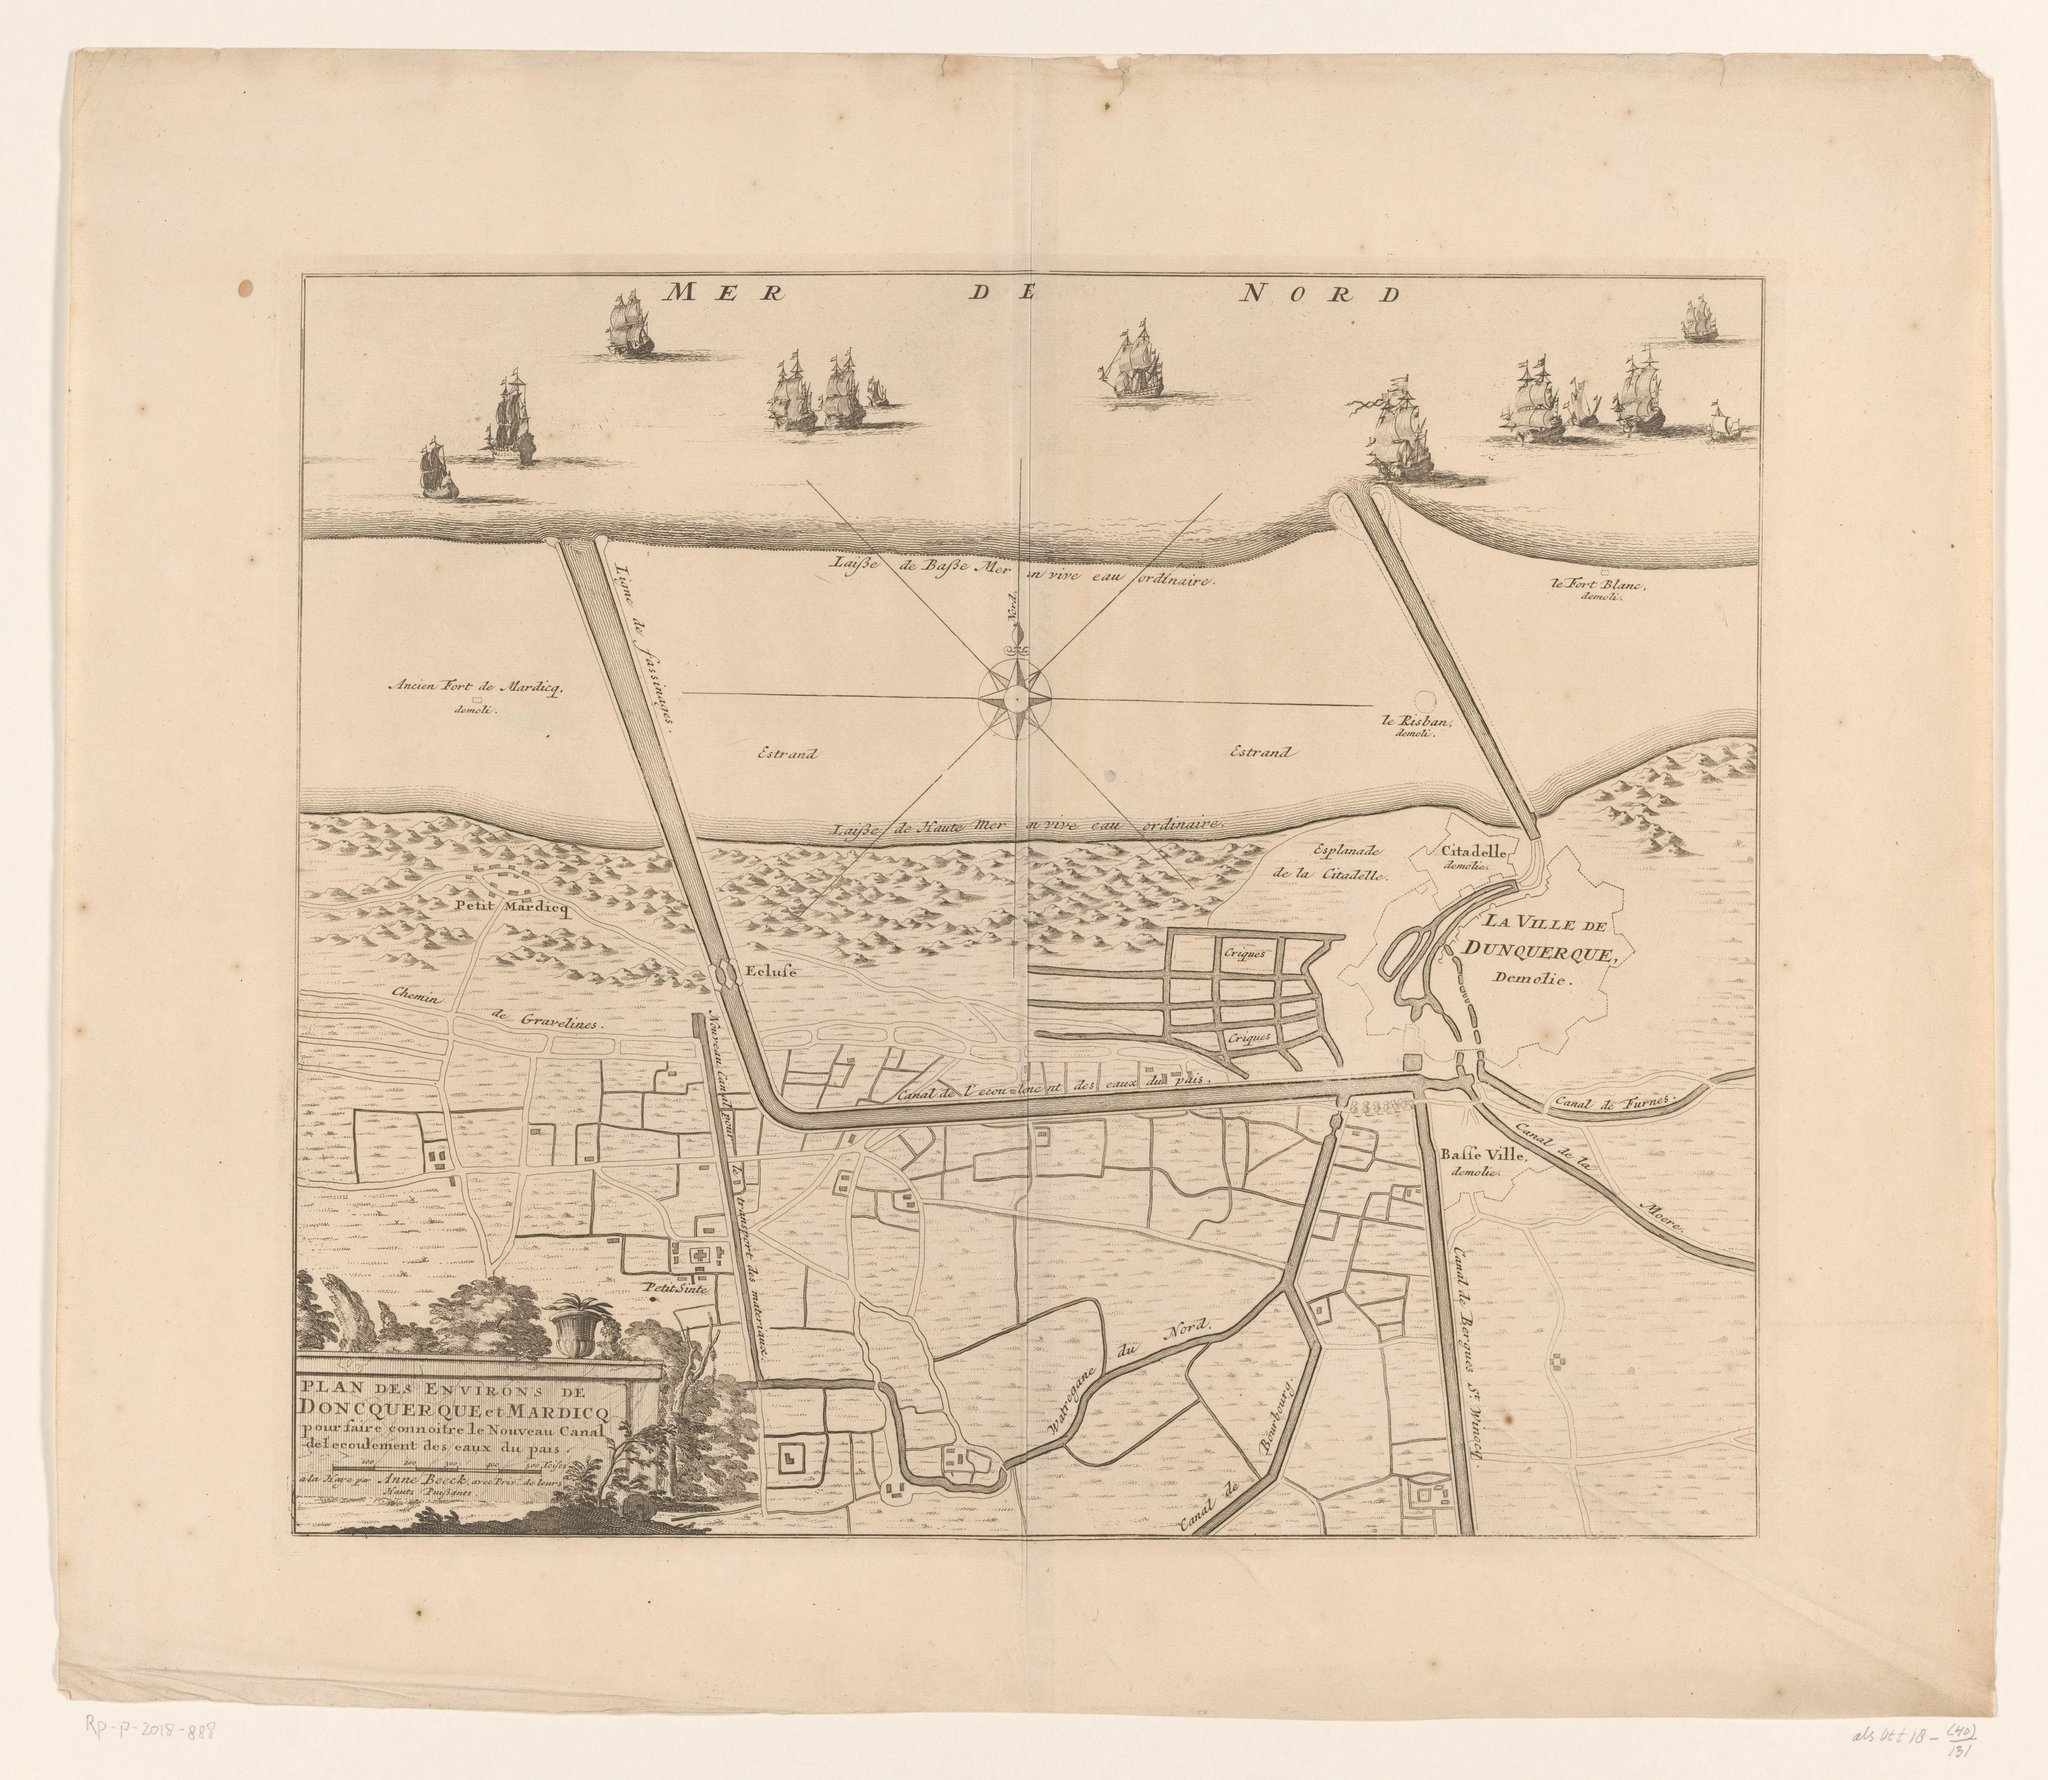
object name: print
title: Plan des environs de Doncquerque et Mardicq pour faire (...)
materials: paper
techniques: engraving, etching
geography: the hague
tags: construction of canal, maps of separate countries or regions, canal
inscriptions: collector's mark: Lugt 2228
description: Kaart met de kanalen van Duinkerke. Te zien is een nieuw gebouwde kanaal, dat Sint-Winoksbergen direct met de zee zou verbinden. Linksonder de titelcartouche met onderin een schaalstok: 500 Toises.